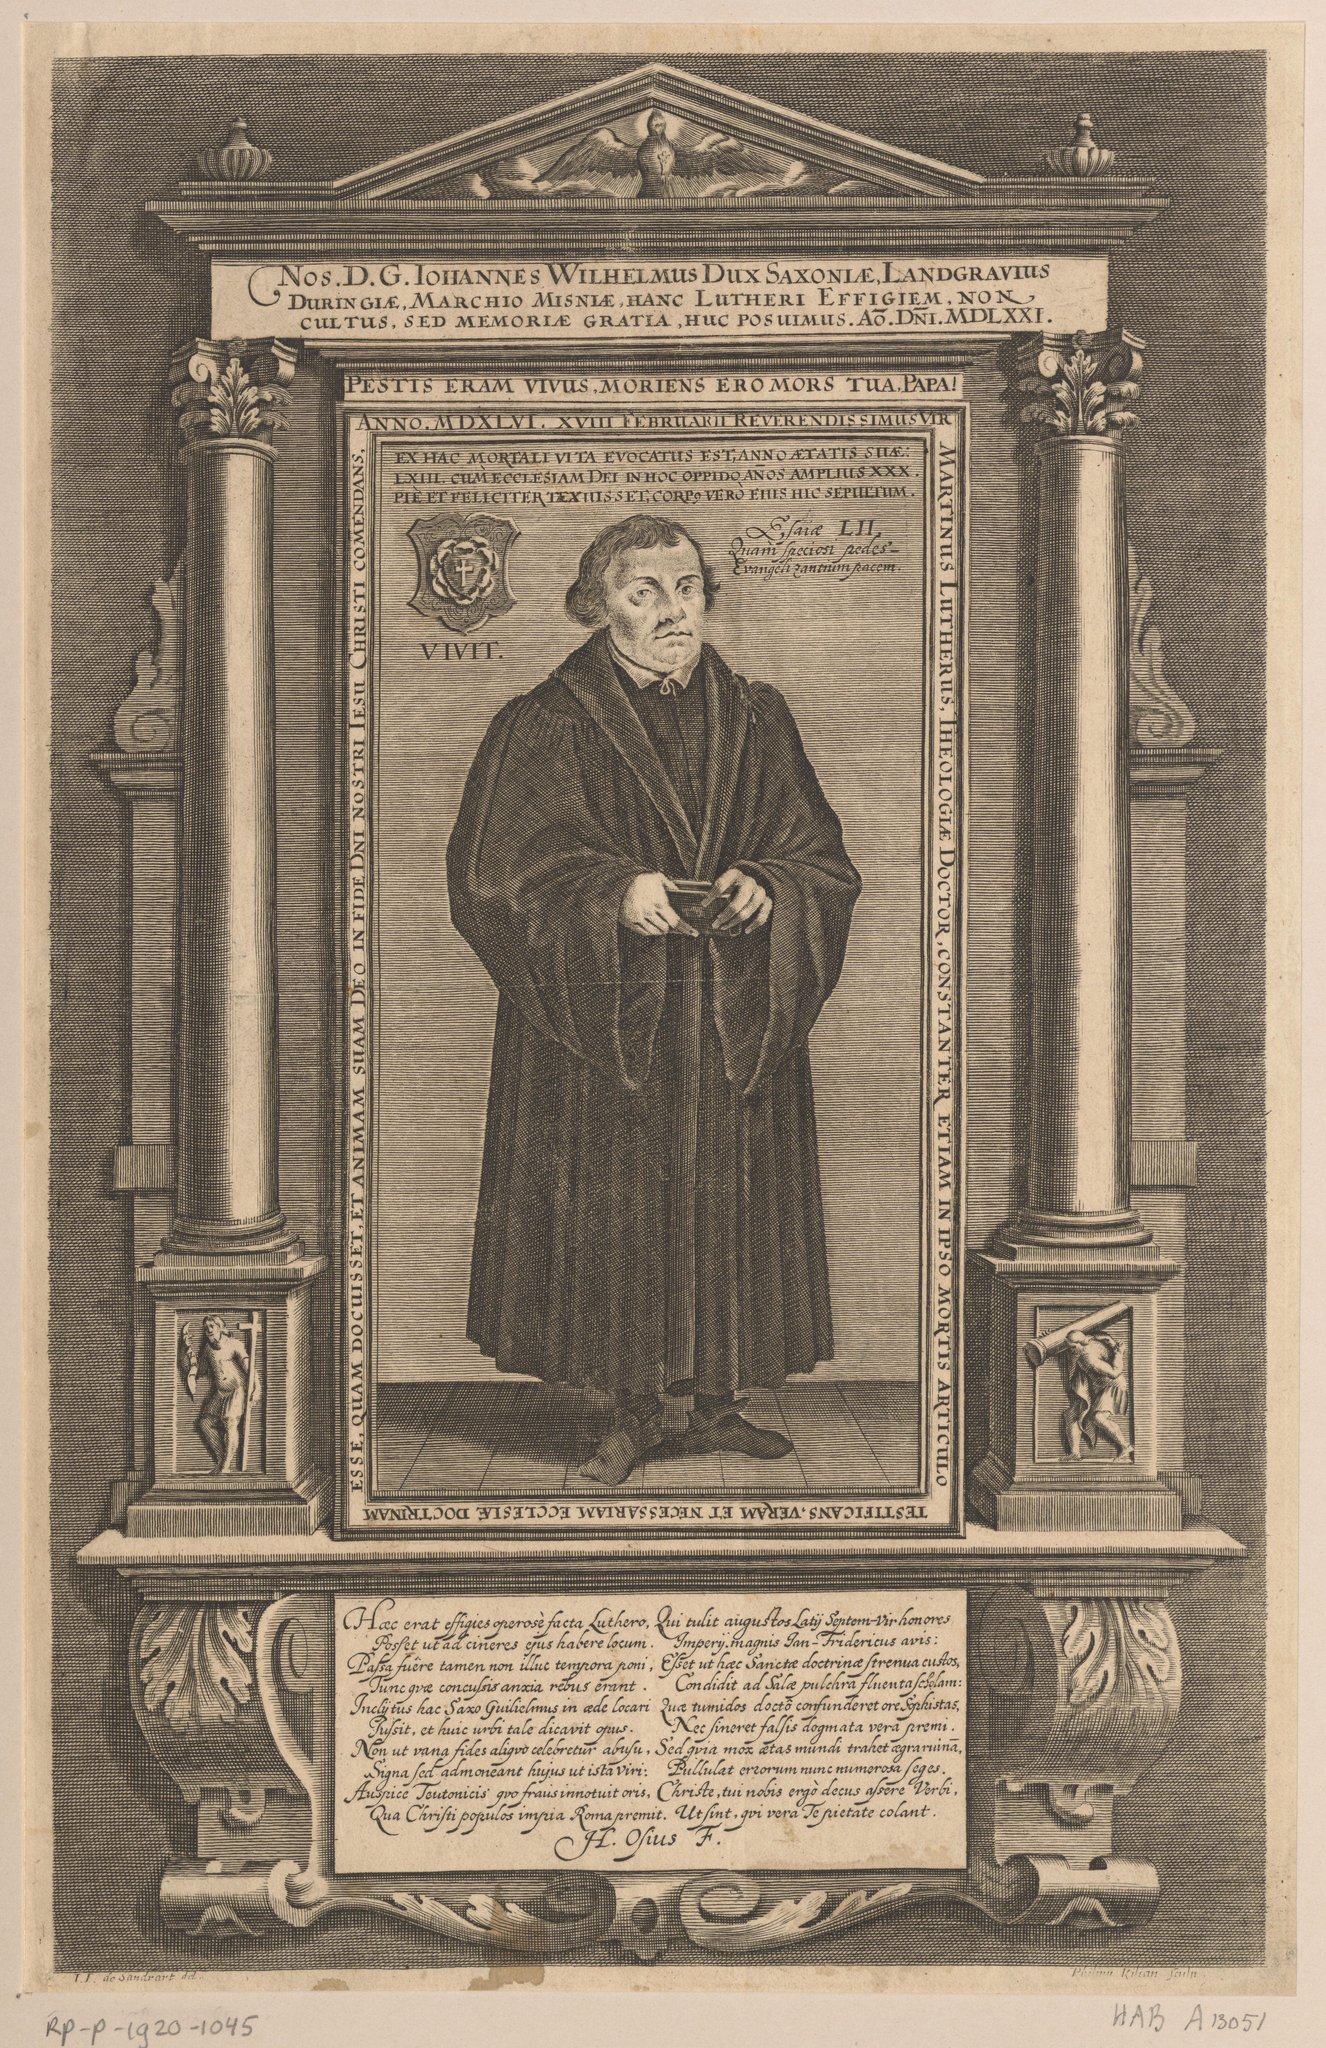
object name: print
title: Gedenkmonument voor Martin Luther in de Slotkerk te Wittenberg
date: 1665-1693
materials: paper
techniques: engraving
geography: germany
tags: priest, martin luther, fortitude, 'fortitudo' ~ one of the four cardinal virtues, faith, 'fides'; 'fede', 'fede catholica', 'fede christiana', 'fede christiana catholica' (ripa) ~ one of the three theological virtues, column, pillar ~ architecture, theologian, historical persons, grave, tomb and other grave-forms and grave-markers, armorial bearing, heraldry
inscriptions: collector's mark: Lugt 2228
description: Met twintigregelig vers in twee kolommen in het Latijn. Op het monument verschillende regels tekst in het Latijn.